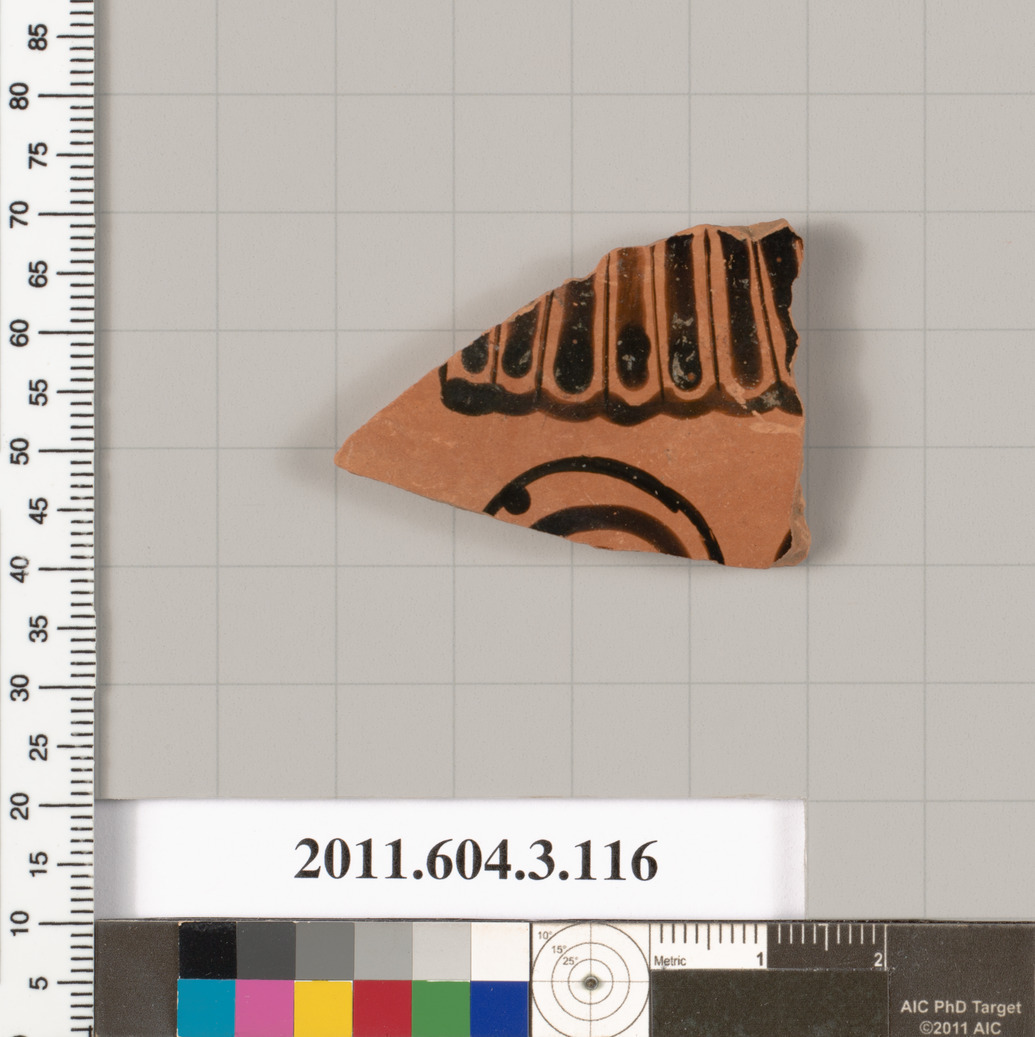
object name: amphora fragment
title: Terracotta fragment of an amphora (jar)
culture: greek, attic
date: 510-500 BCE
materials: terracotta